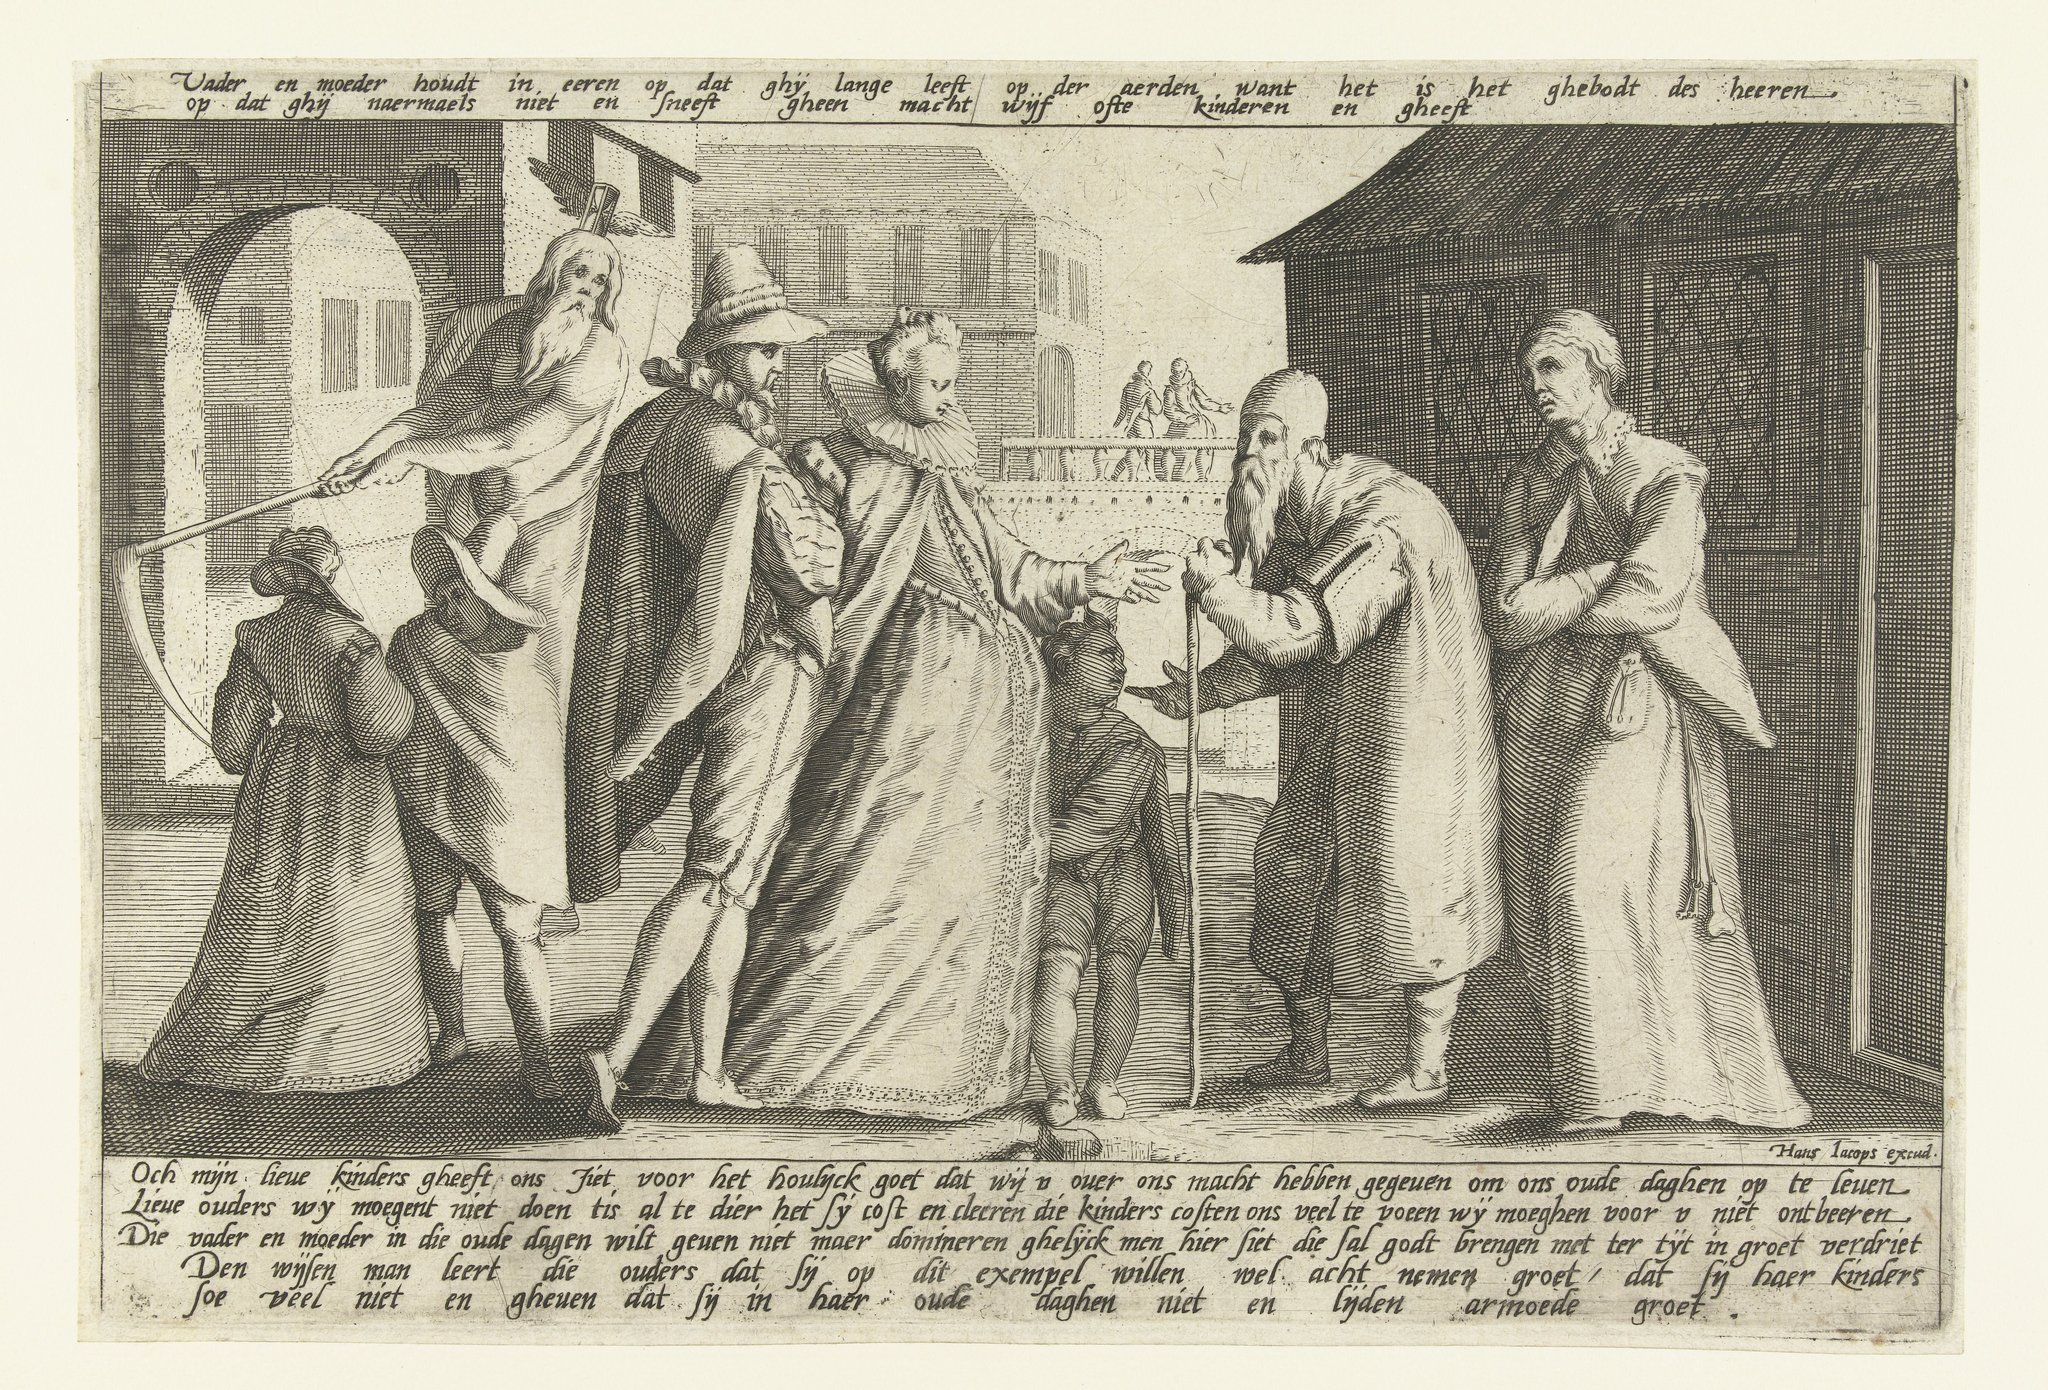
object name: print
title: Poor Parents, Rich Children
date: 1580-1634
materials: paper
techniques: engraving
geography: antwerp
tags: death as old man, poor parents, rich children (absence of filial love)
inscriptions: collector's mark: Lugt 240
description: The parents have sacrificed to educate their son. When, in old age, the struggling couple beseeches him to share some of his riches, he refuses: his own children cost him too much. In doing so, he violates the Fifth Commandment: Honour thy Father and thy Mother. But the parents are also to blame; they should not have spent all their money on their son.